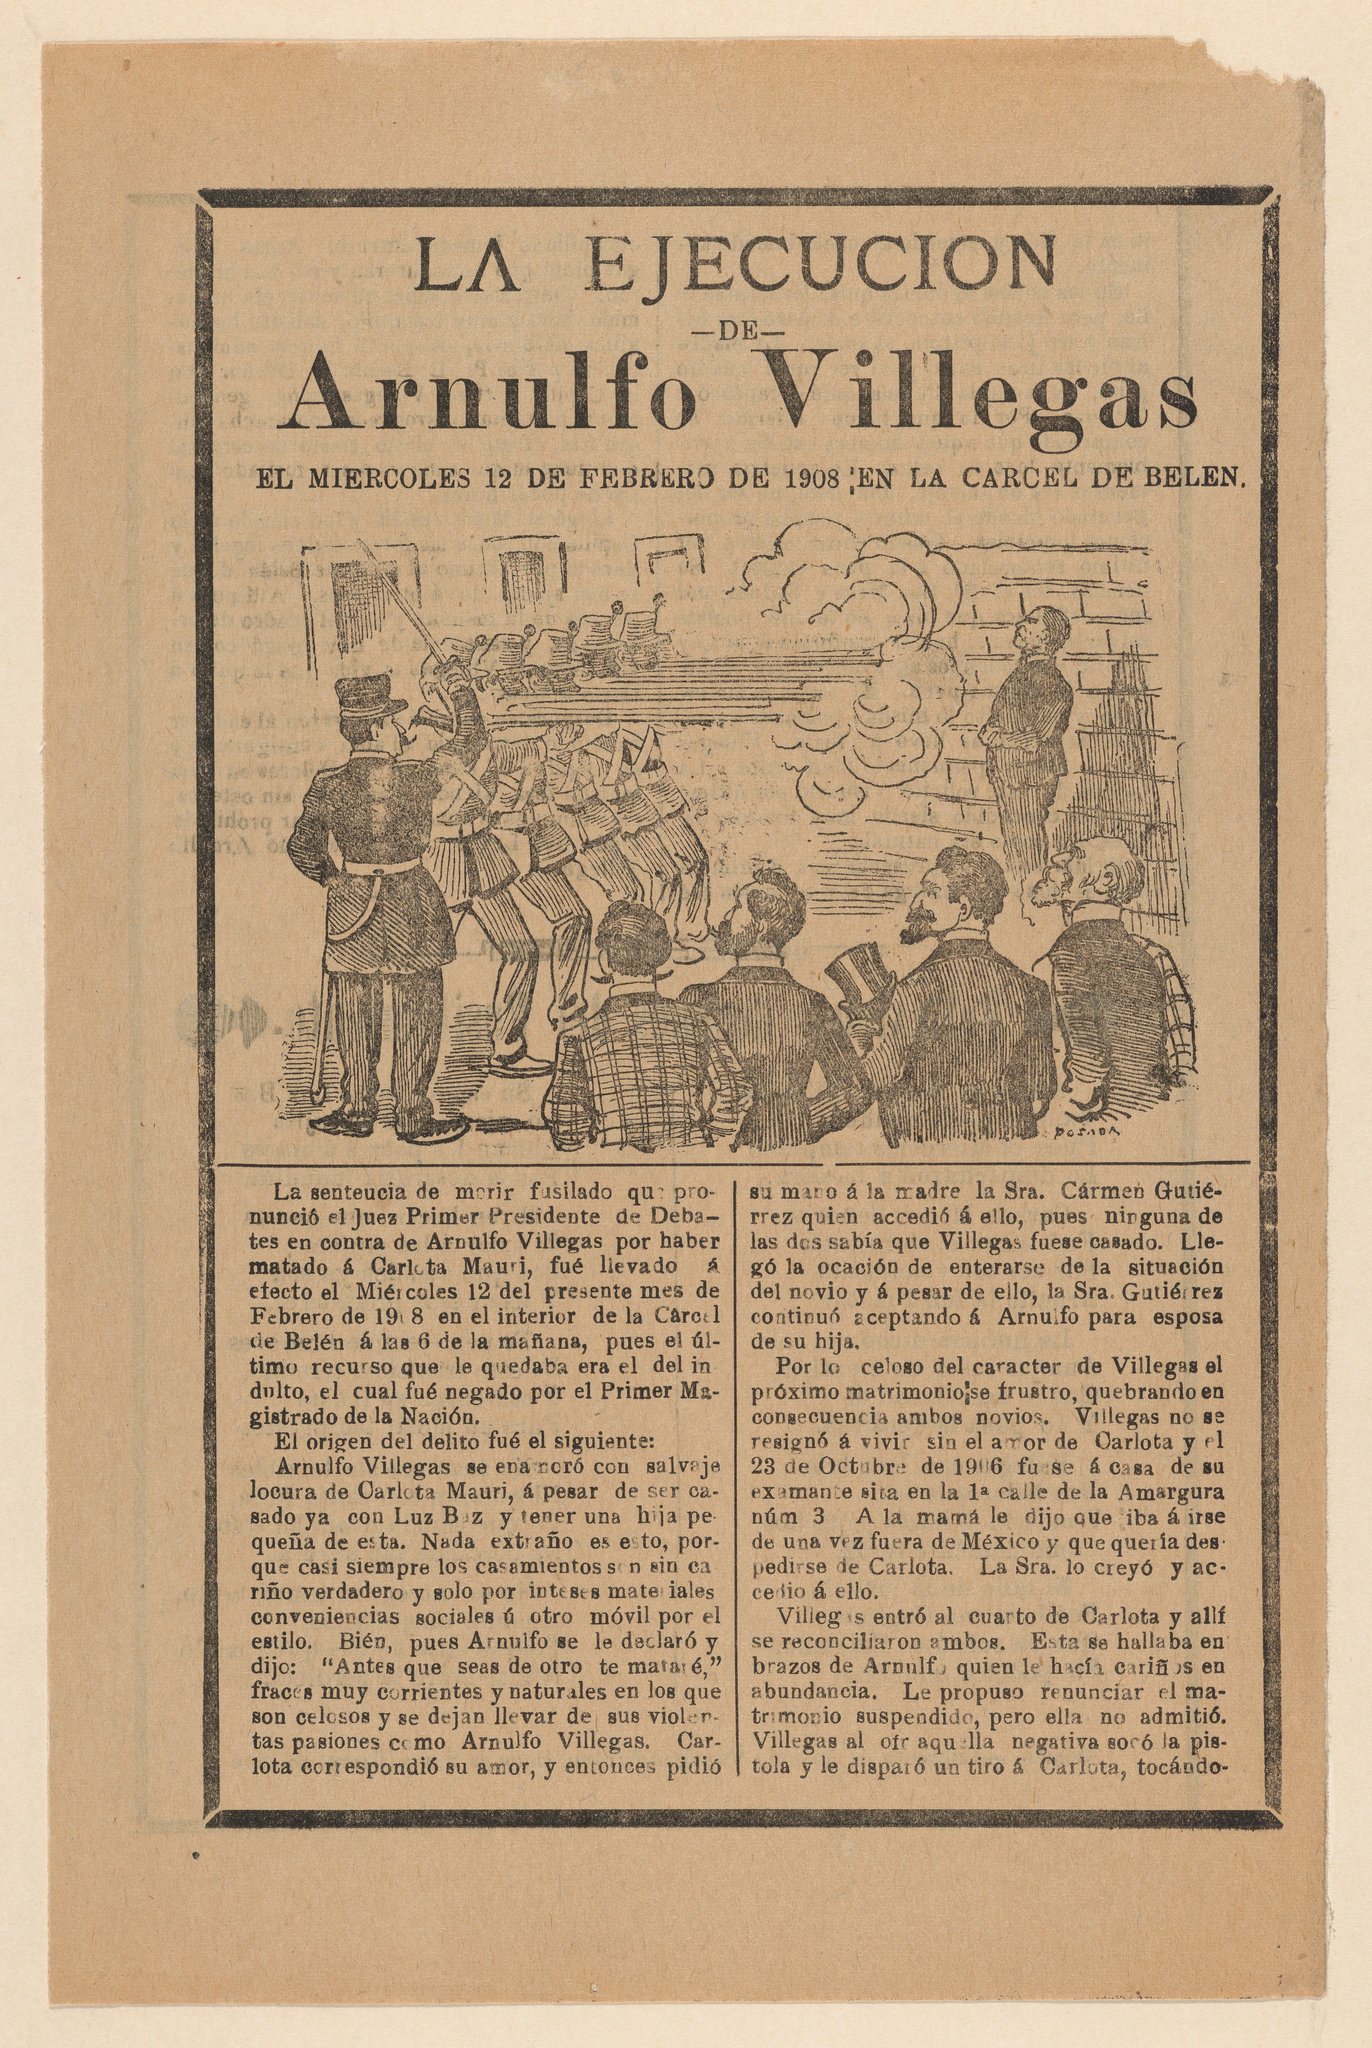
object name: print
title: Broadsheet relating to the execution of Arnulfo Villegas in the Belen prison on 12 February 1908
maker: josé guadalupe posada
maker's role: artist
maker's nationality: mexican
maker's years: 1852-1913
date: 1908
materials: paper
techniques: letterpress, lithography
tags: soldiers,men,execution